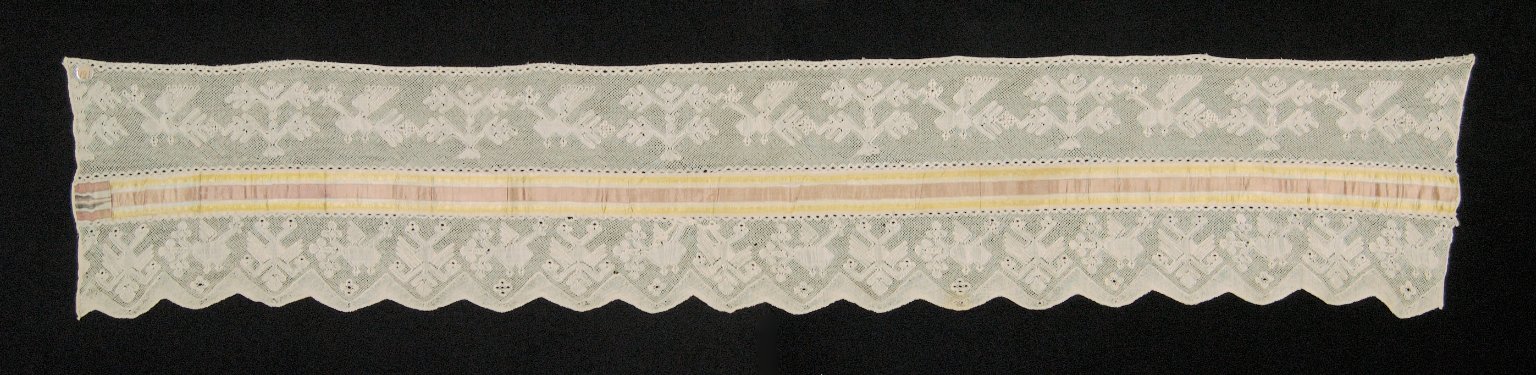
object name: border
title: Bed curtain border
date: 1780-1820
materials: linen, silk